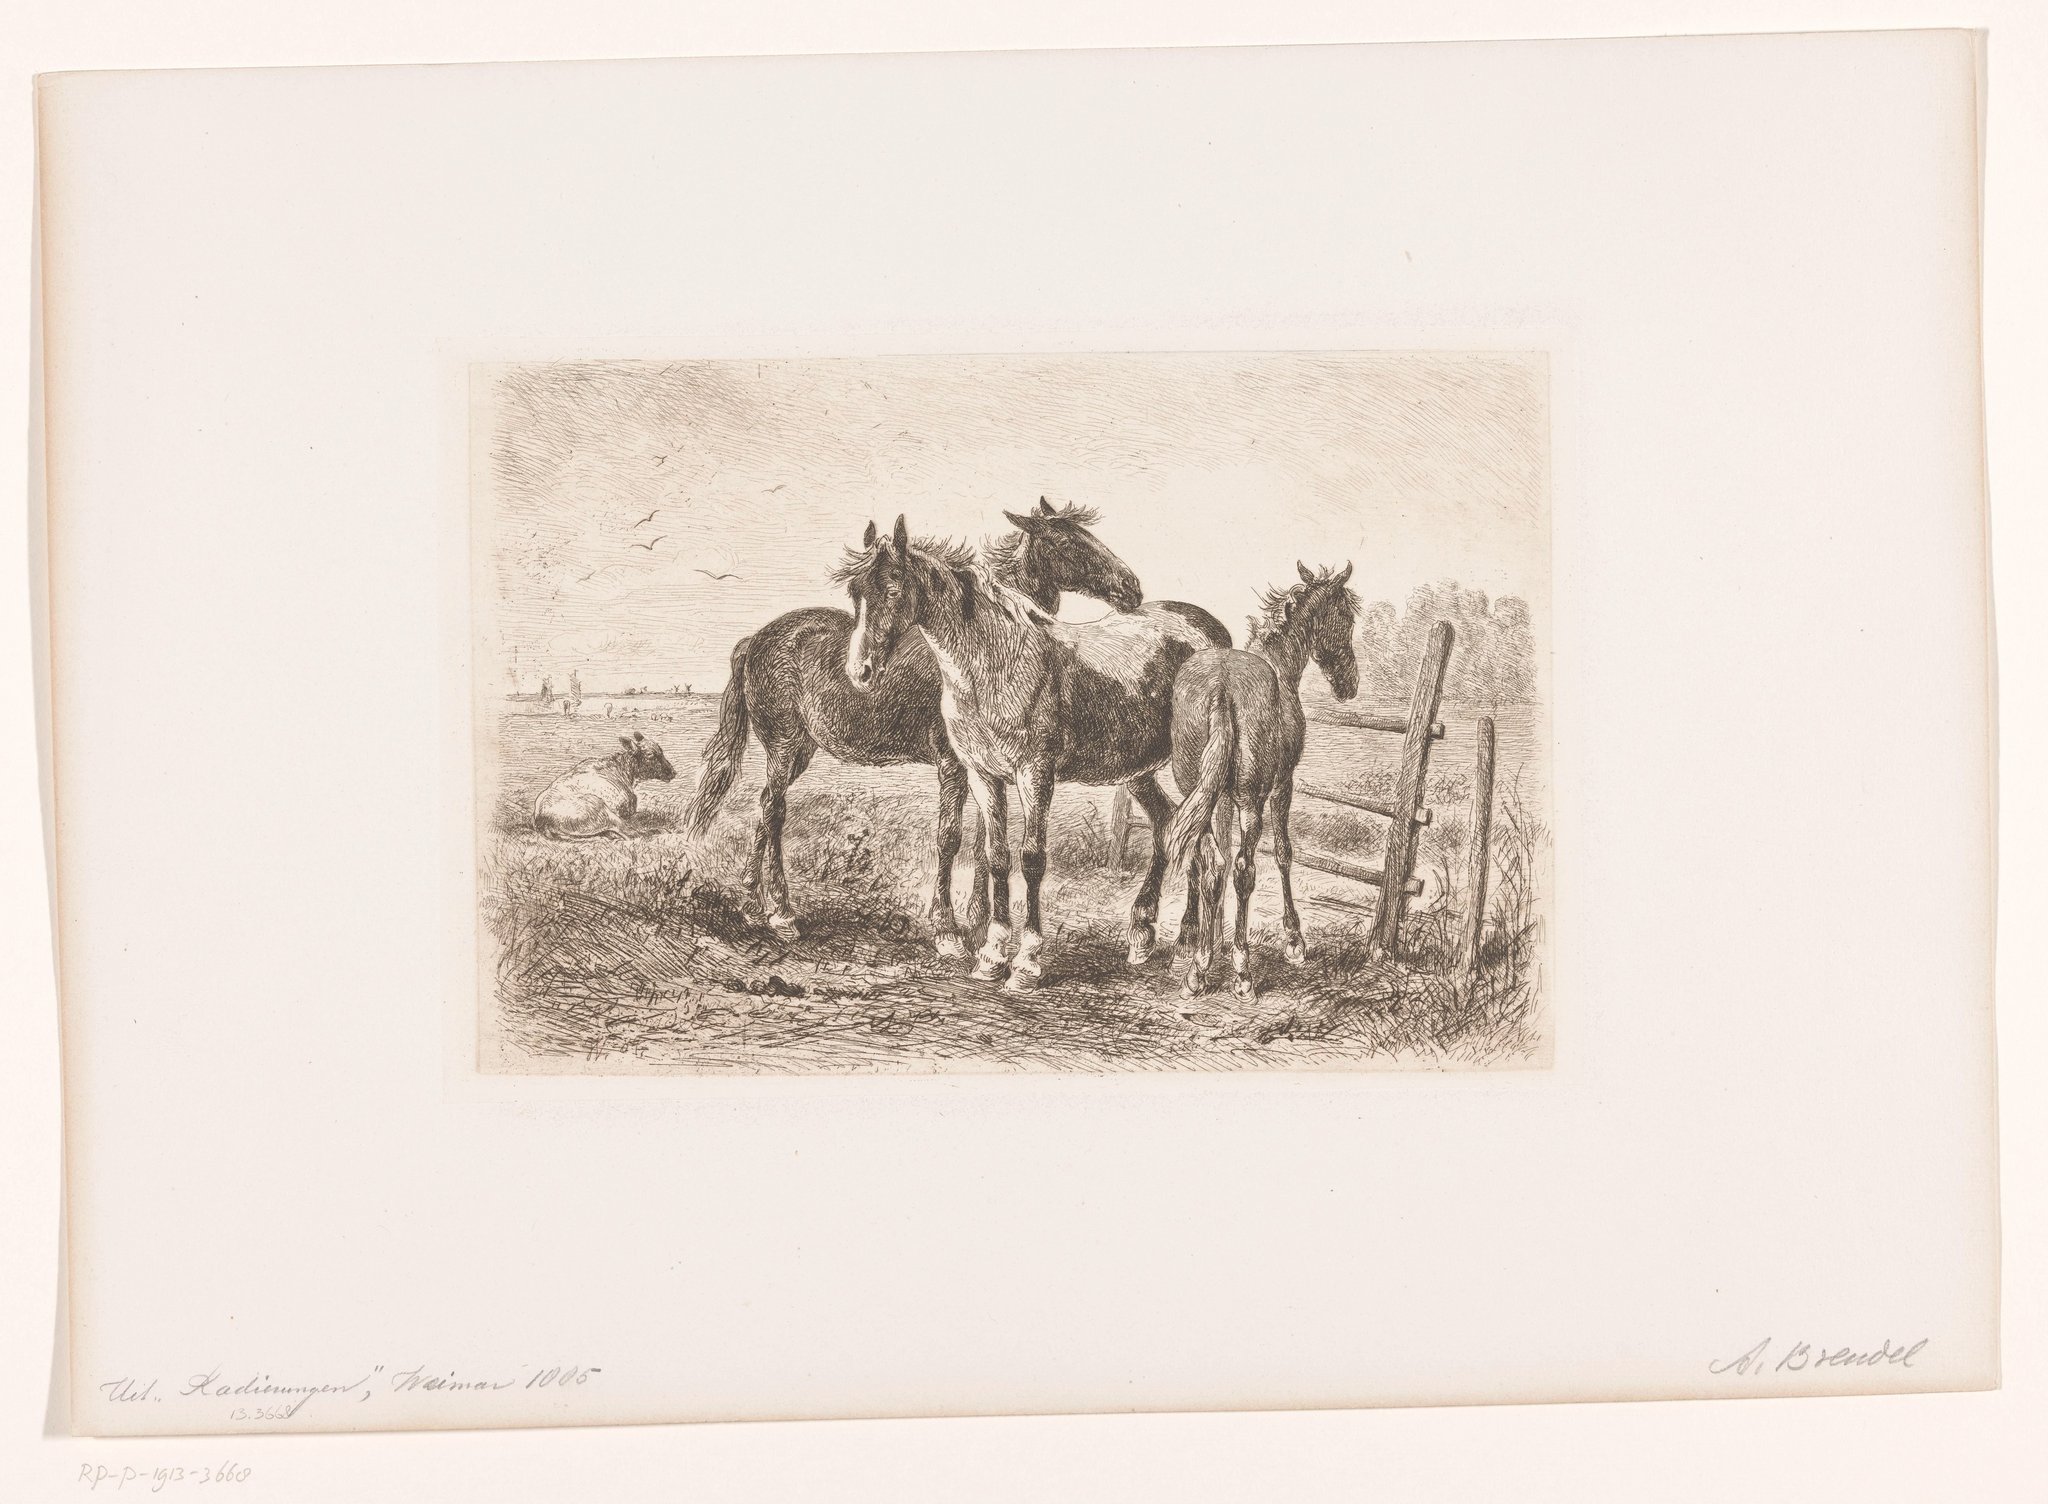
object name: print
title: Drie paarden in een weiland, een koe in de achtergrond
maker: albert heinrich brendel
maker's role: print maker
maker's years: 1827-1895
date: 1884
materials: paper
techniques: etching, intaglio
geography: weimar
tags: cow, meadow, pasture, horse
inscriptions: collector's mark: Lugt 2228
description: Prent maakt deel uit van een groep prenten die tussen 1880 en 1888 werd uitgegeven door het Gesellschaft für Radierkunst te Weimar.